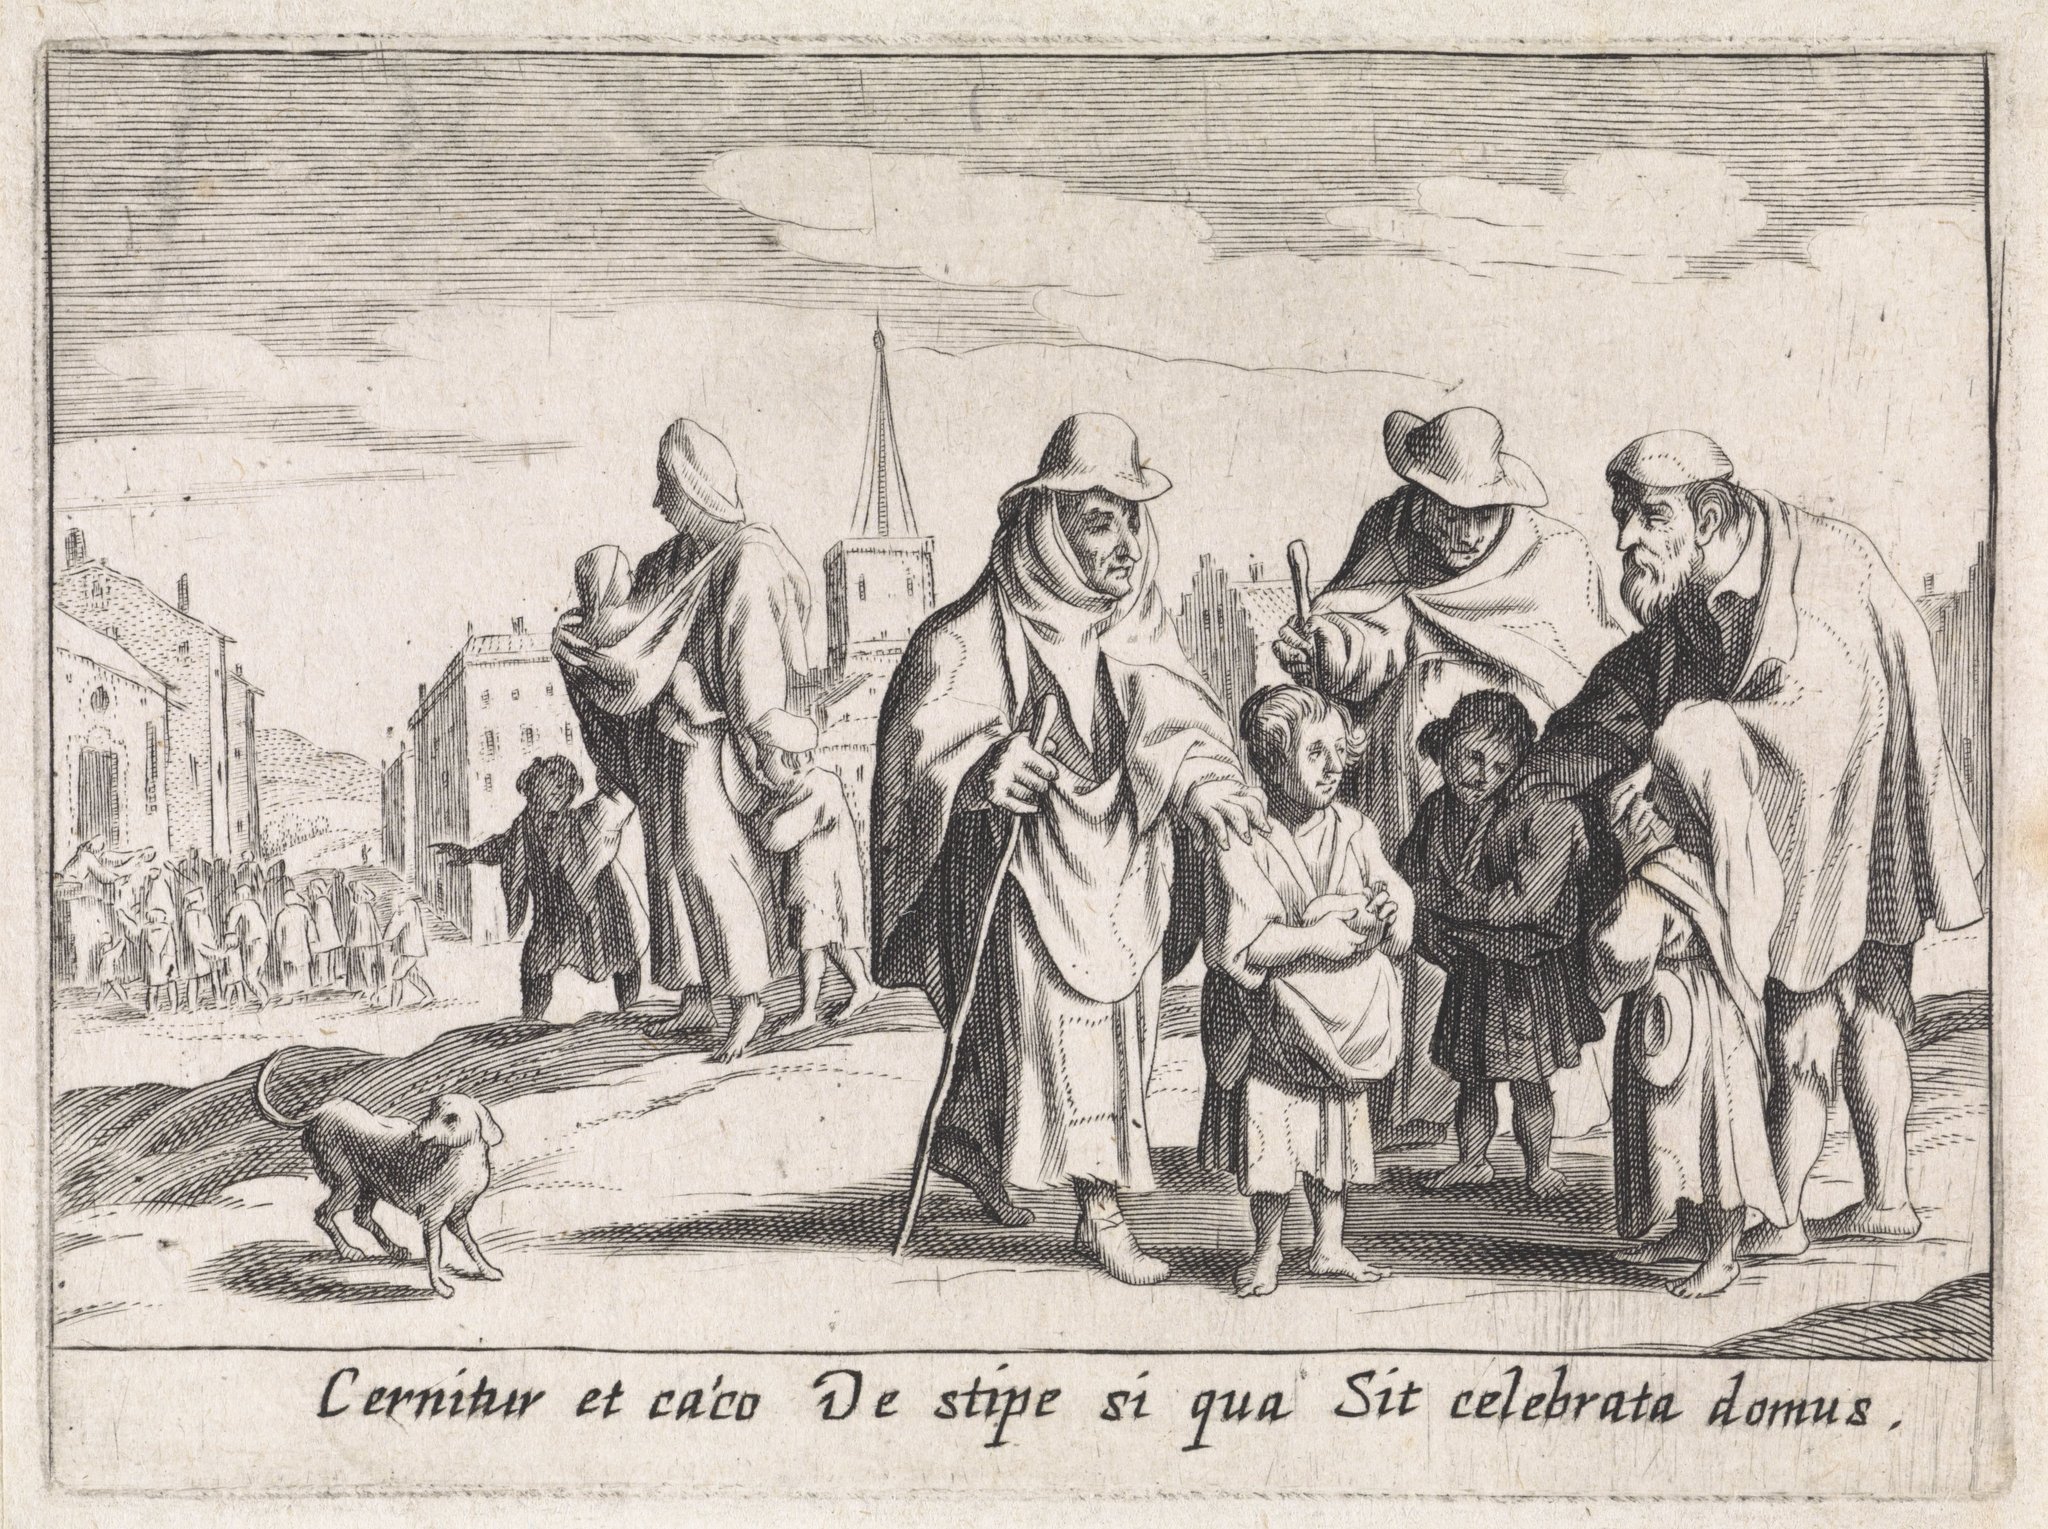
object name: print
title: Het betreurenswaardige lot van de blinden en de armen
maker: Anonymous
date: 1629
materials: paper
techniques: engraving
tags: giving alms or other charity, e.g.: handing out food, the poor, dog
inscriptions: collector's mark: Lugt 240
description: Drie arme mensen lopen op straat. Ze hebben zich ontfermd over drie kinderen. Links op de achtergrond een groep armen die vecht om de aalmoezen die worden uitgedeeld bij de kerk.